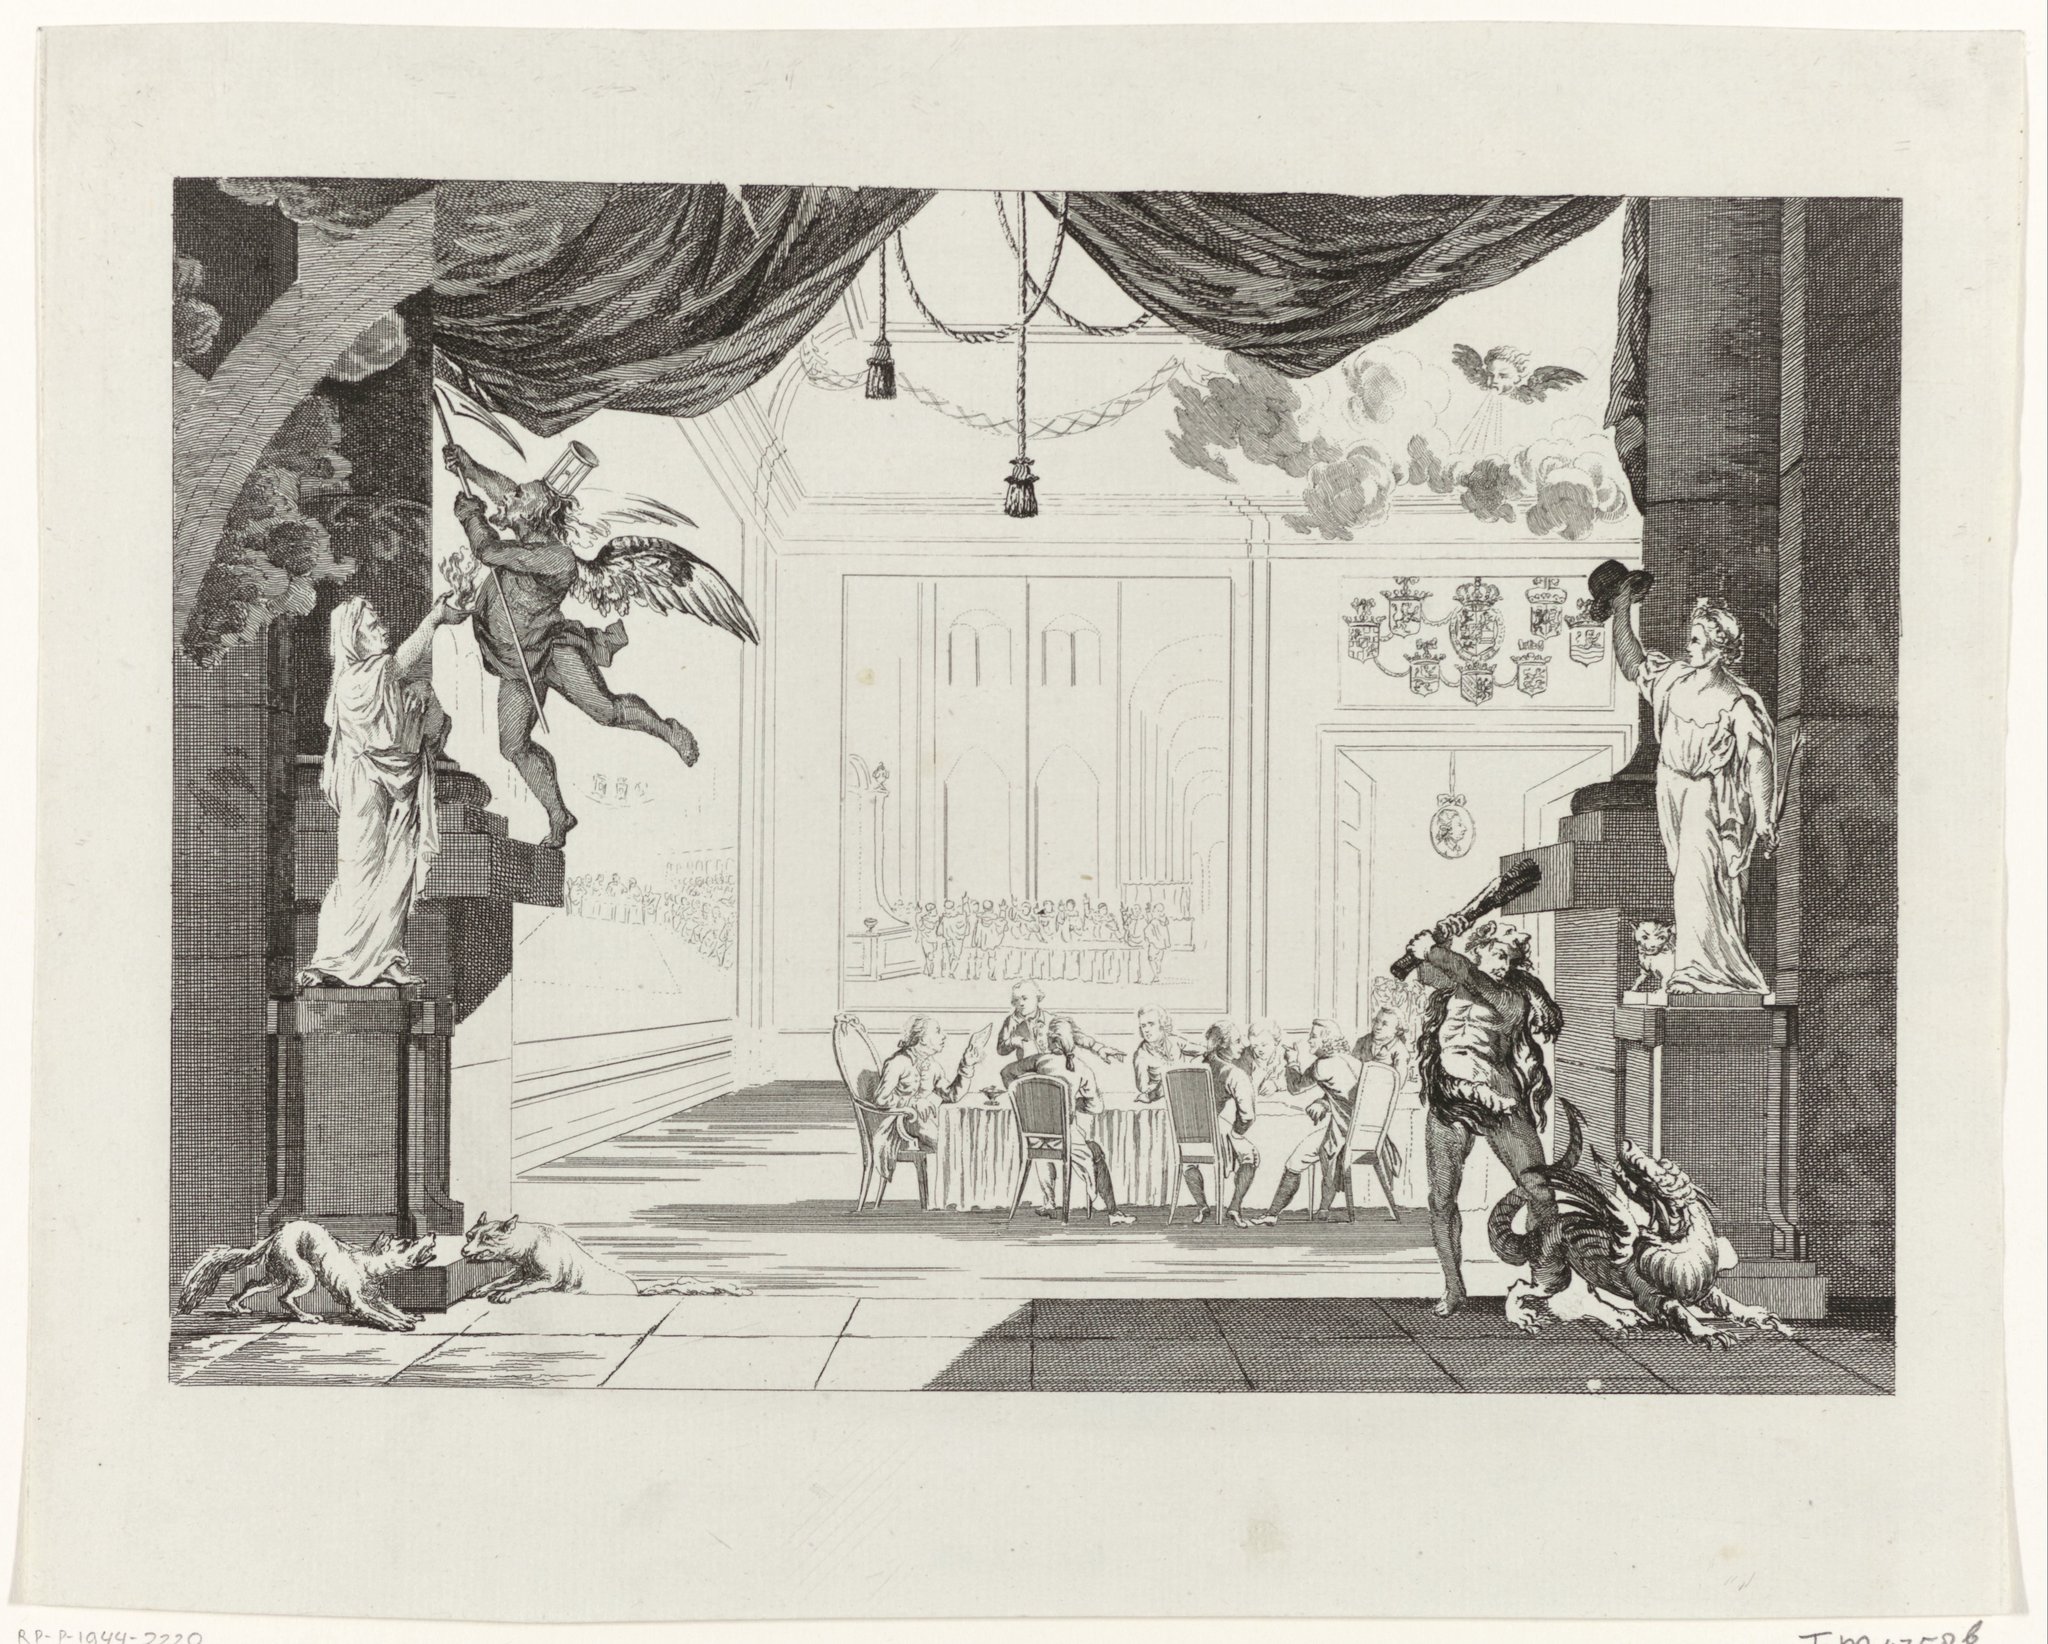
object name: print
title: Allegorie op de oprichting van de Oprechte Vaderlandsche Sociëteit te Rotterdam, 1787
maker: mathias de sallieth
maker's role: print maker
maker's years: 1749-1791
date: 1787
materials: paper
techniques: etching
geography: northern netherlands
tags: the hague, william v (prince of orange), learned society, academy of sciences, (2) the hydra of lerna is killed by hercules, allegorical representations ~ religion; 'religione', 'religione de ss. mauritio e lazaro', 'religione vera christiana' (ripa), father time, man with wings and scythe, freedom, liberty; 'libertà' (ripa) (+ abstract concept represented by female figure), patriots (1780-1795), union of utrecht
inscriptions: collector's mark: Lugt 2228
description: Allegorie op de oprichting van het orangistische genootschap de Oprechte Vaderlandsche Sociëteit te Rotterdam, 7 of 18 januari 1787. Interieur met mannen zittend rond een tafel, aan de muren voorstellingen van de Unie van Utrecht (1579) en de Dordtse Synode (1618-1619). Op de voorgrond tilt Vader Tijd de gordijn omhoog en onthult beelden van de Godsdienst, de Vrijheid en van Hercules die de Hydra verslaat. Op de achtergrond het portret van prins Willem V aan de wand van een volgende kamer.